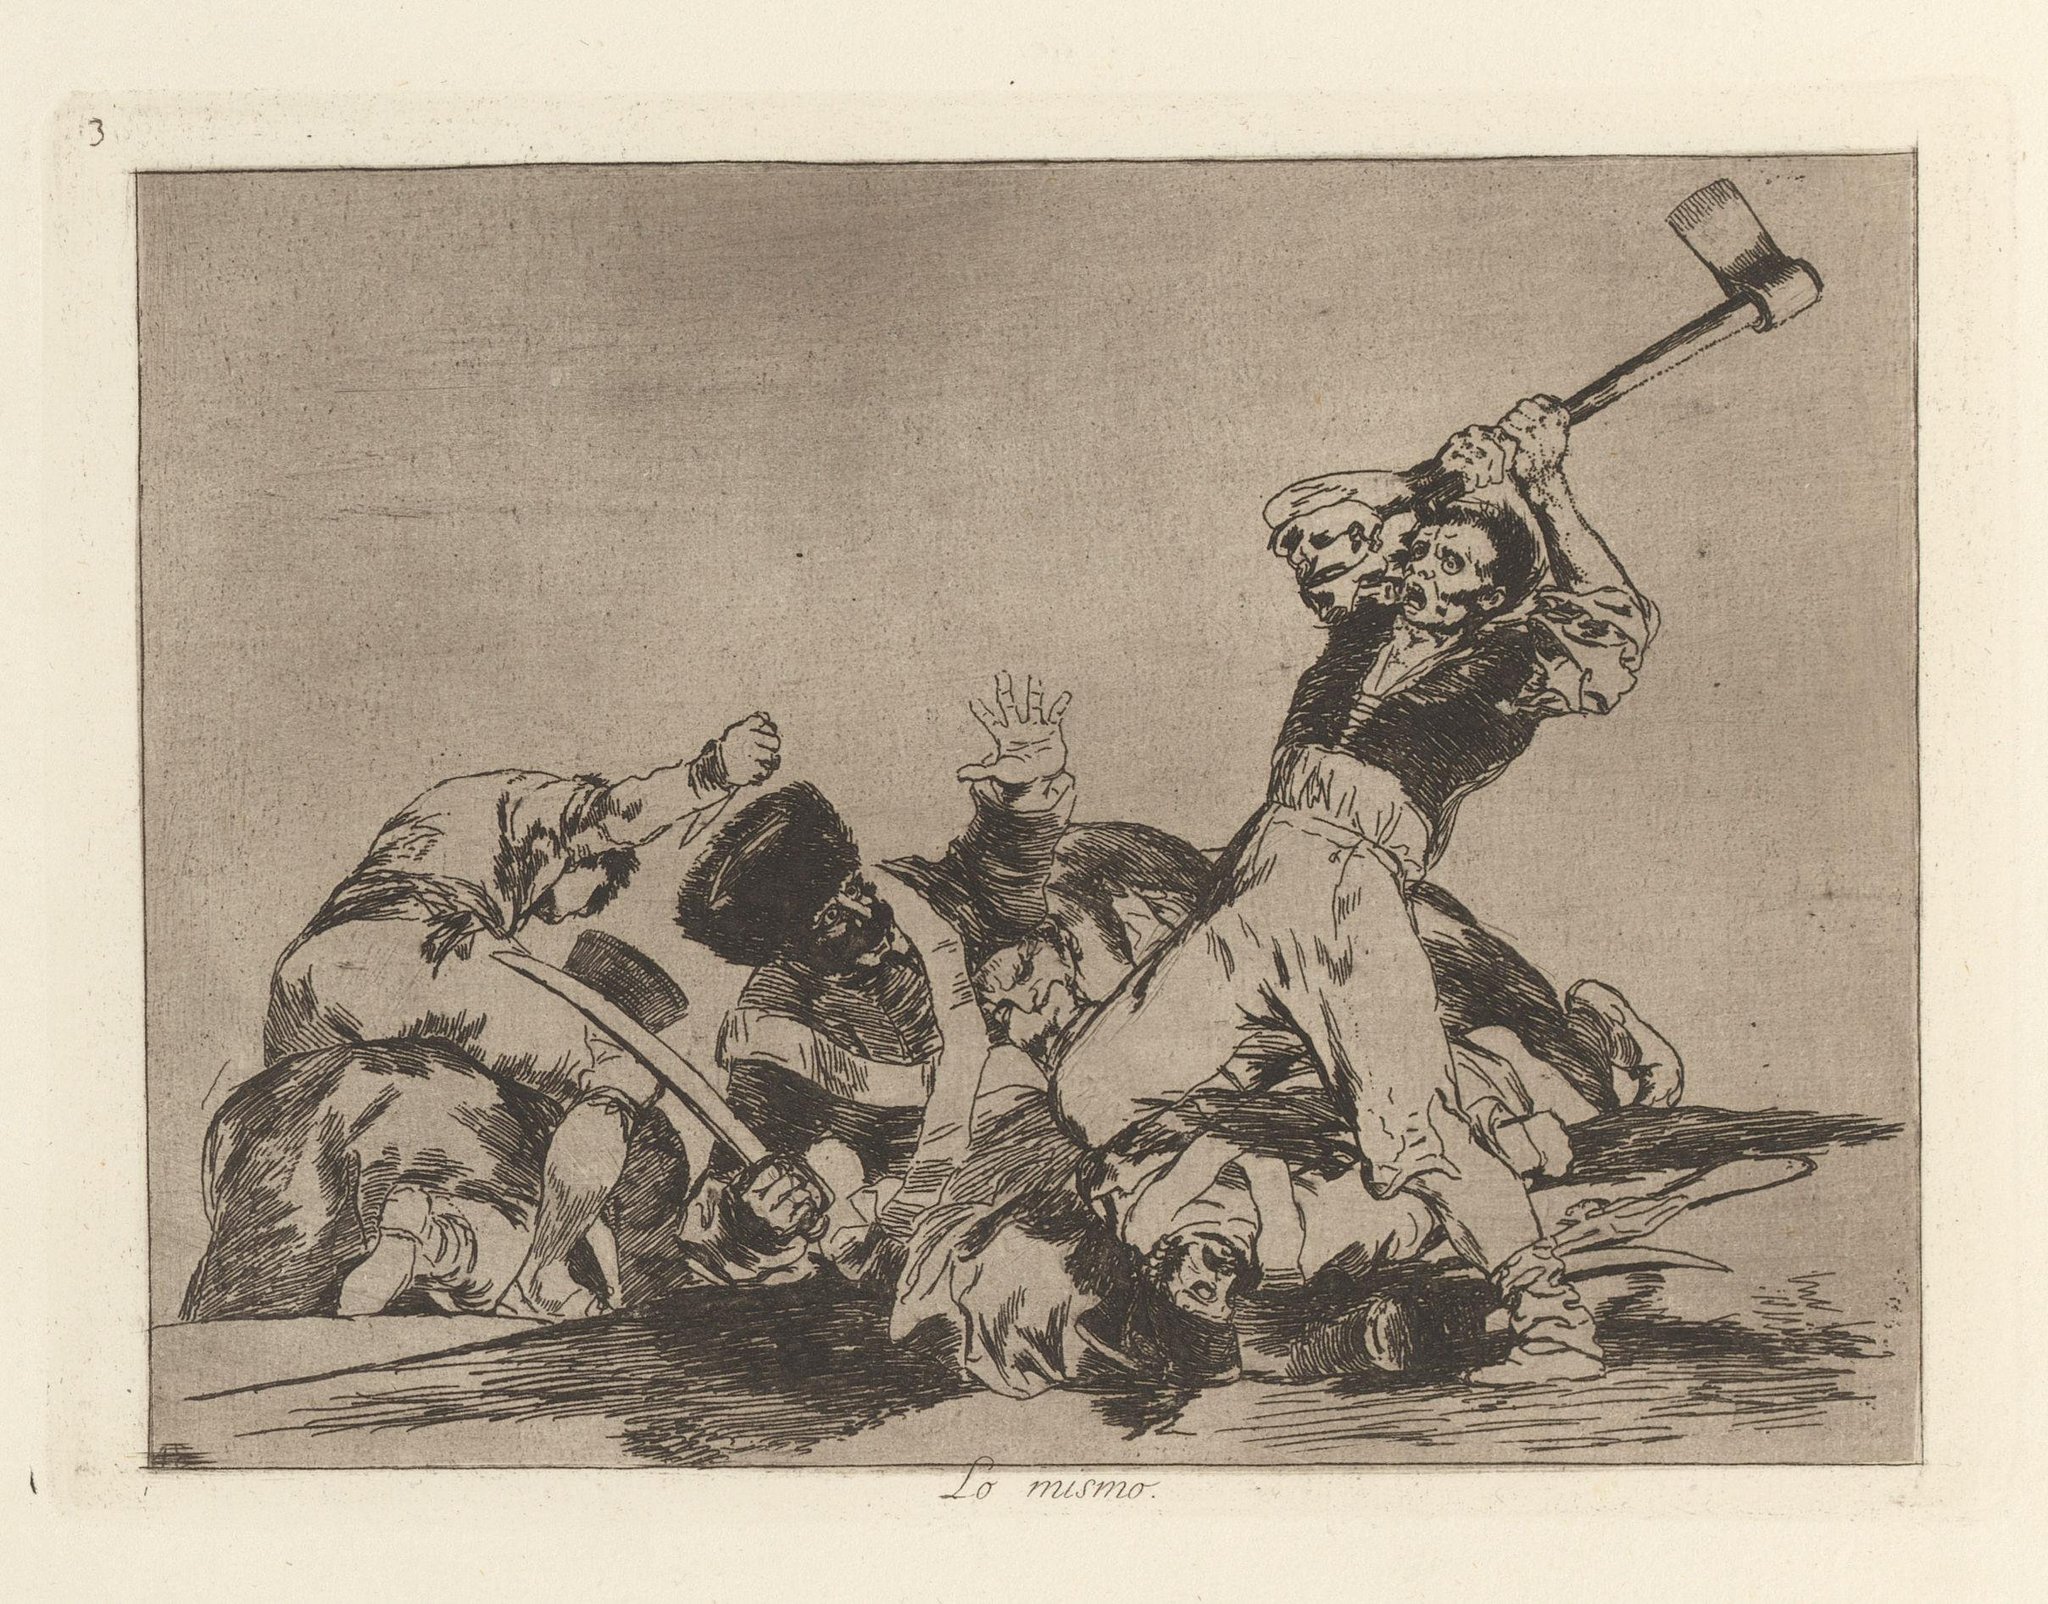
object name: print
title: Lo mismo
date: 1810-1820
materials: paper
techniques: aquatint, drypoint, etching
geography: madrid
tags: hand-to-hand fighting (~ battle), horrors of war, spain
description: Deze prent maakt deel uit van een album.